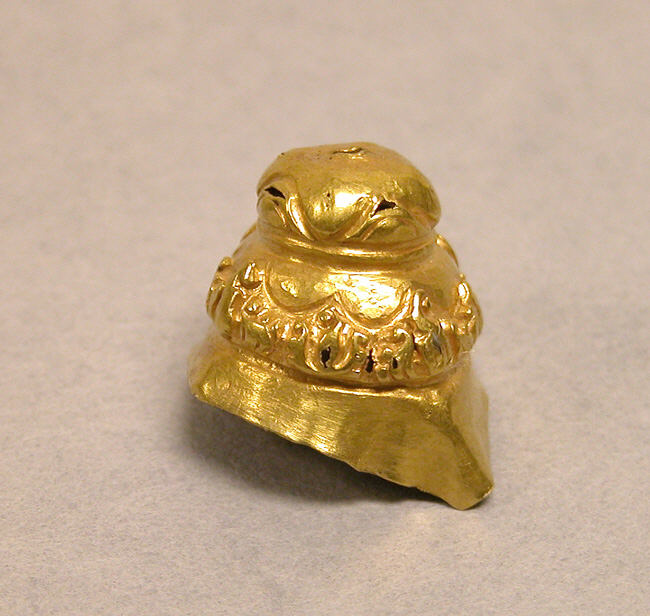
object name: ornament band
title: Ornament: band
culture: indonesian, central java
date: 701-1200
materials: gold